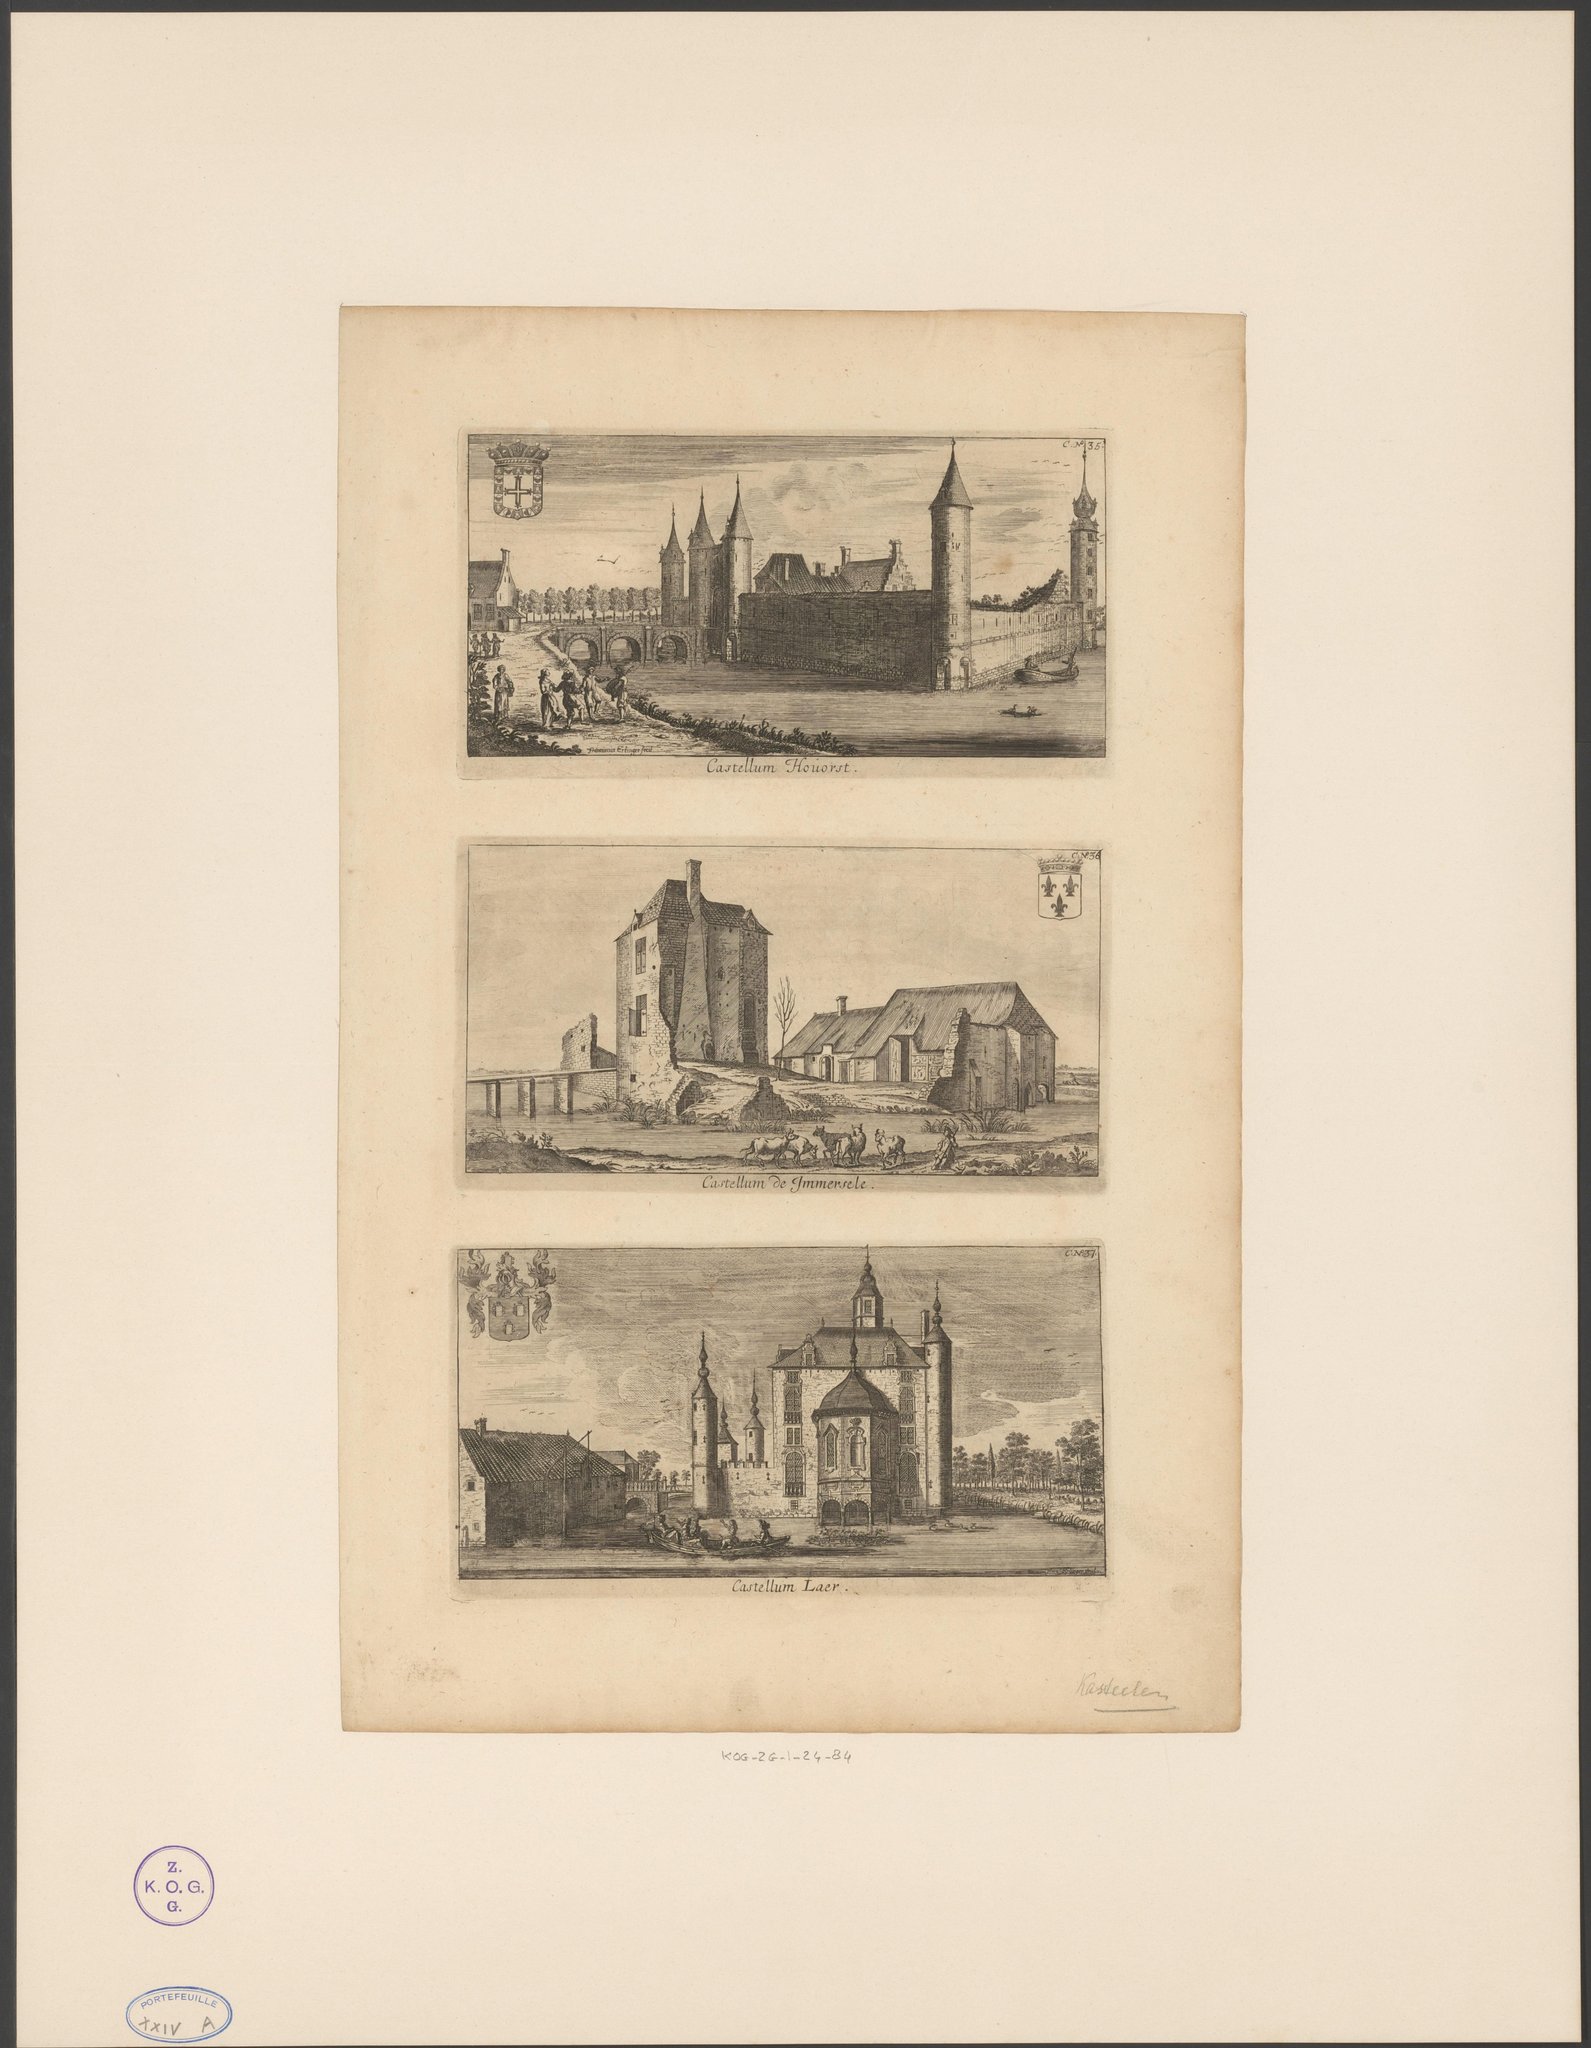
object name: print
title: Castellum Houorst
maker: franz ertinger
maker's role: print maker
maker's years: 1640-1710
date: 1678-1730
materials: paper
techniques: engraving, etching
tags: castle, armorial bearing, heraldry, viersel, antwerp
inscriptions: stamp, collector's mark: Lugt 1641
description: Van deze prenten bestaan in ieder geval vijf staten. De eerste staat is gebruikt in: Roys, Jacques le. Notitia Marchionatus Sacri Romani Imperii (…). Amsterdam: Franciscus Lamming, 1678. De tweede en derde staat komt voor in latere uitgaven van Le Roys werk (tweede: 1692, 1699, 1705, 1706; derde: 1730). De vierde staat is gebruikt in: Cantillons, Philippe de. Delices du Brabant et de ses campagnes (…). Amsterdam: Jean Neaulme, 1757. De vijfde staat komt voor in: Cantillon, Philippe de. Vermakelykheden van Brabant, en deszelfs onderhoorige landen (…). 4 dln. 1e druk. Amsterdam: David Weege, 1770, dl. 3. En in: Cantillon, Philippe de. Vermakelykheden van Brabant, en deszelfs onderhoorige landen (…). 4 dln. 2e druk. Utrecht: Gijsbert Tieme van Paddenburg en Justus Visch, 1777, dl. 3. Huidige staat is de tweede of derde staat.